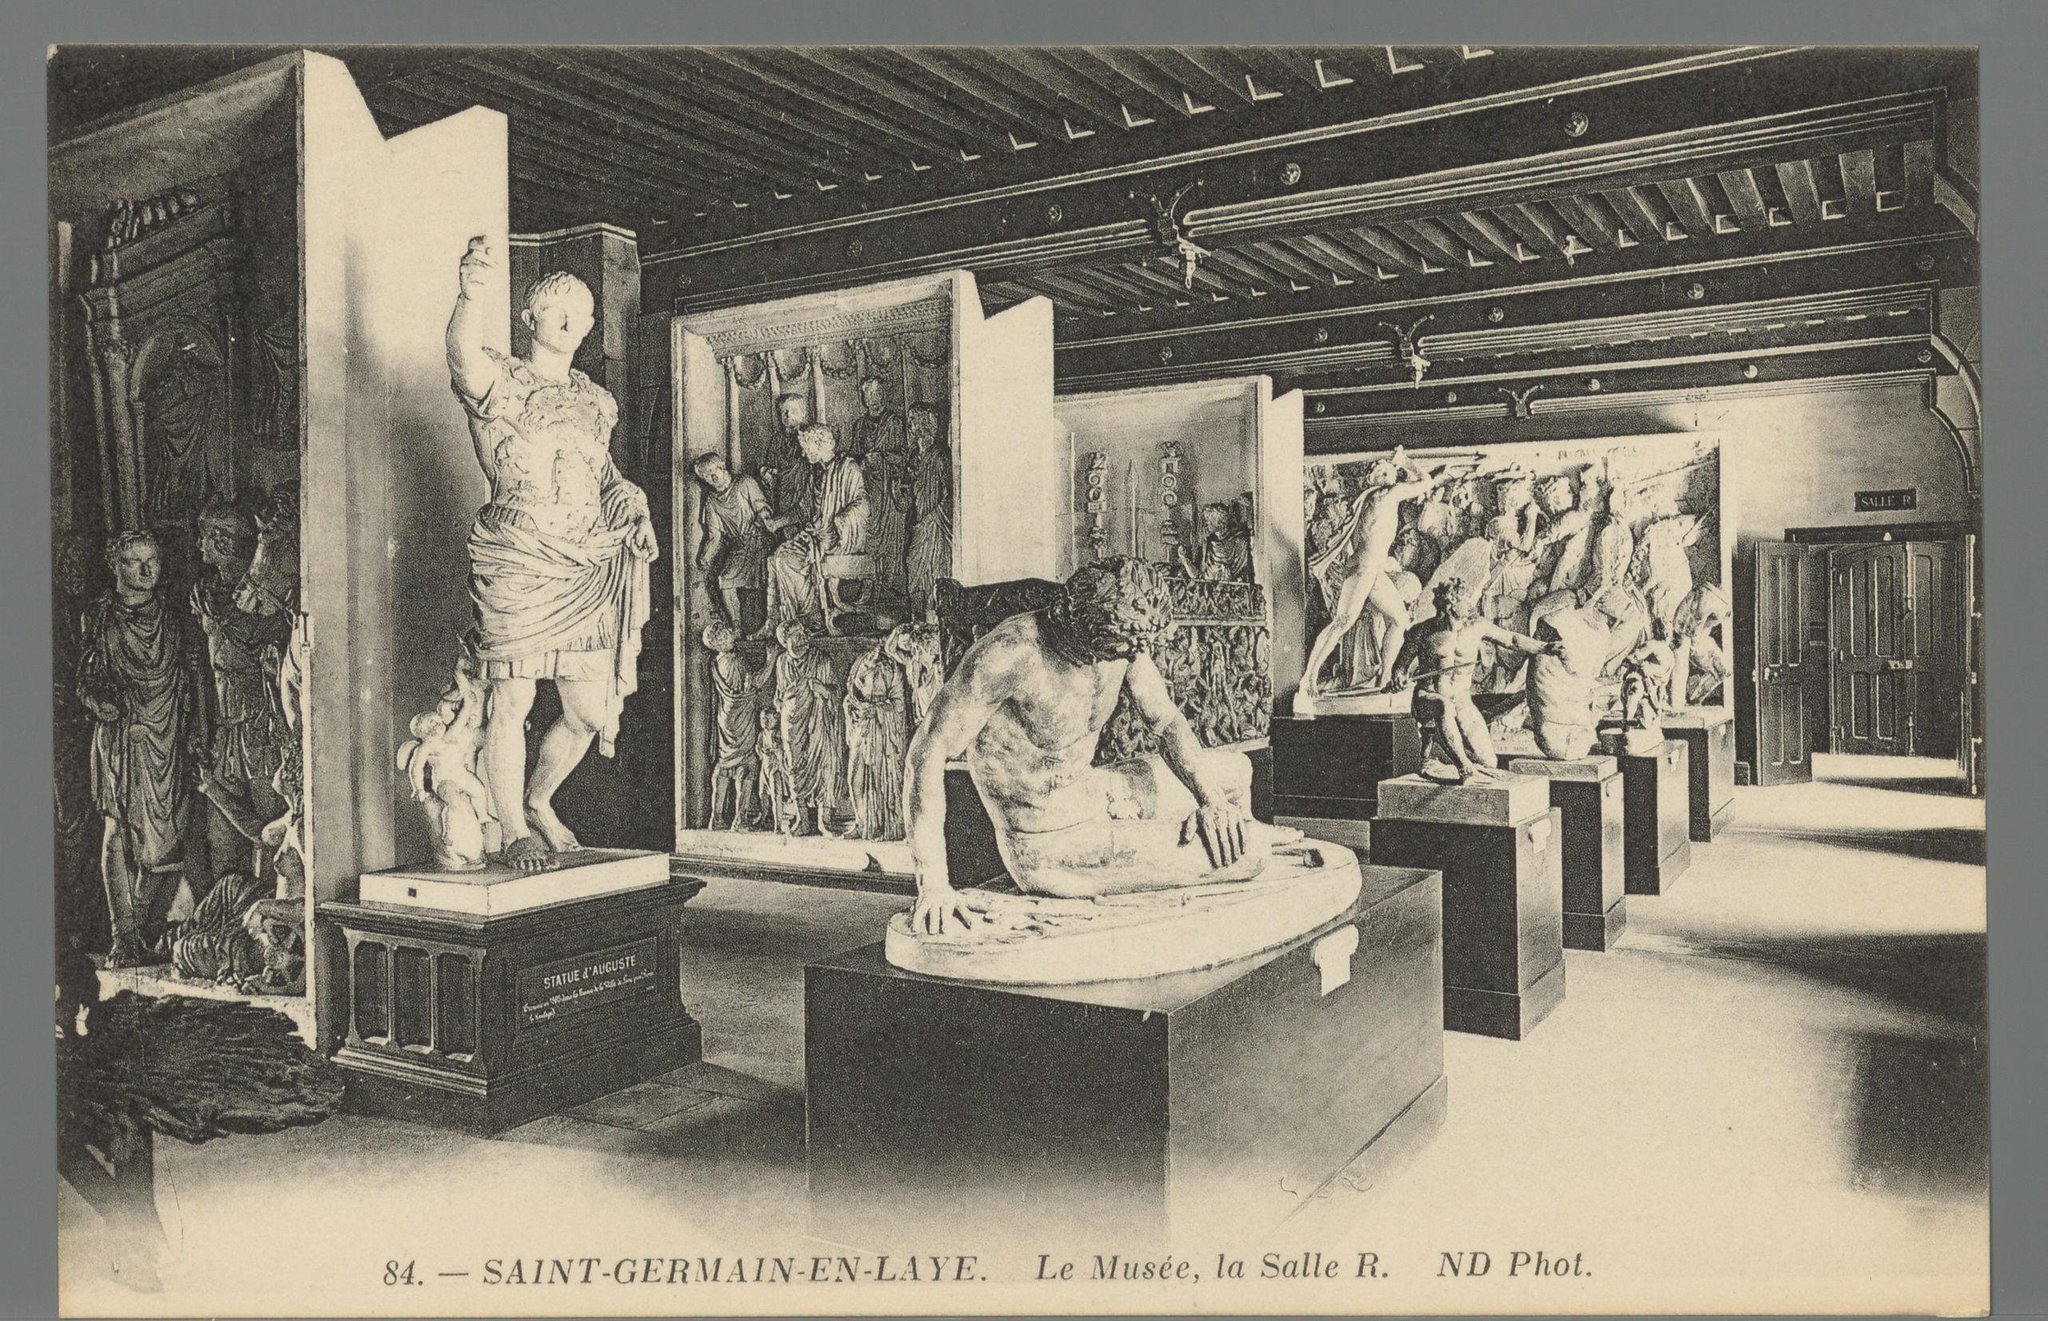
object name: photomechanical print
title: Le Musée, la Salle R.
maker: Anonymous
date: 1903-1918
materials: cardboard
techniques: photograph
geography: saint-germain-en-laye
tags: permanent exhibition, museum, sculpture, interior ~ representation of a building